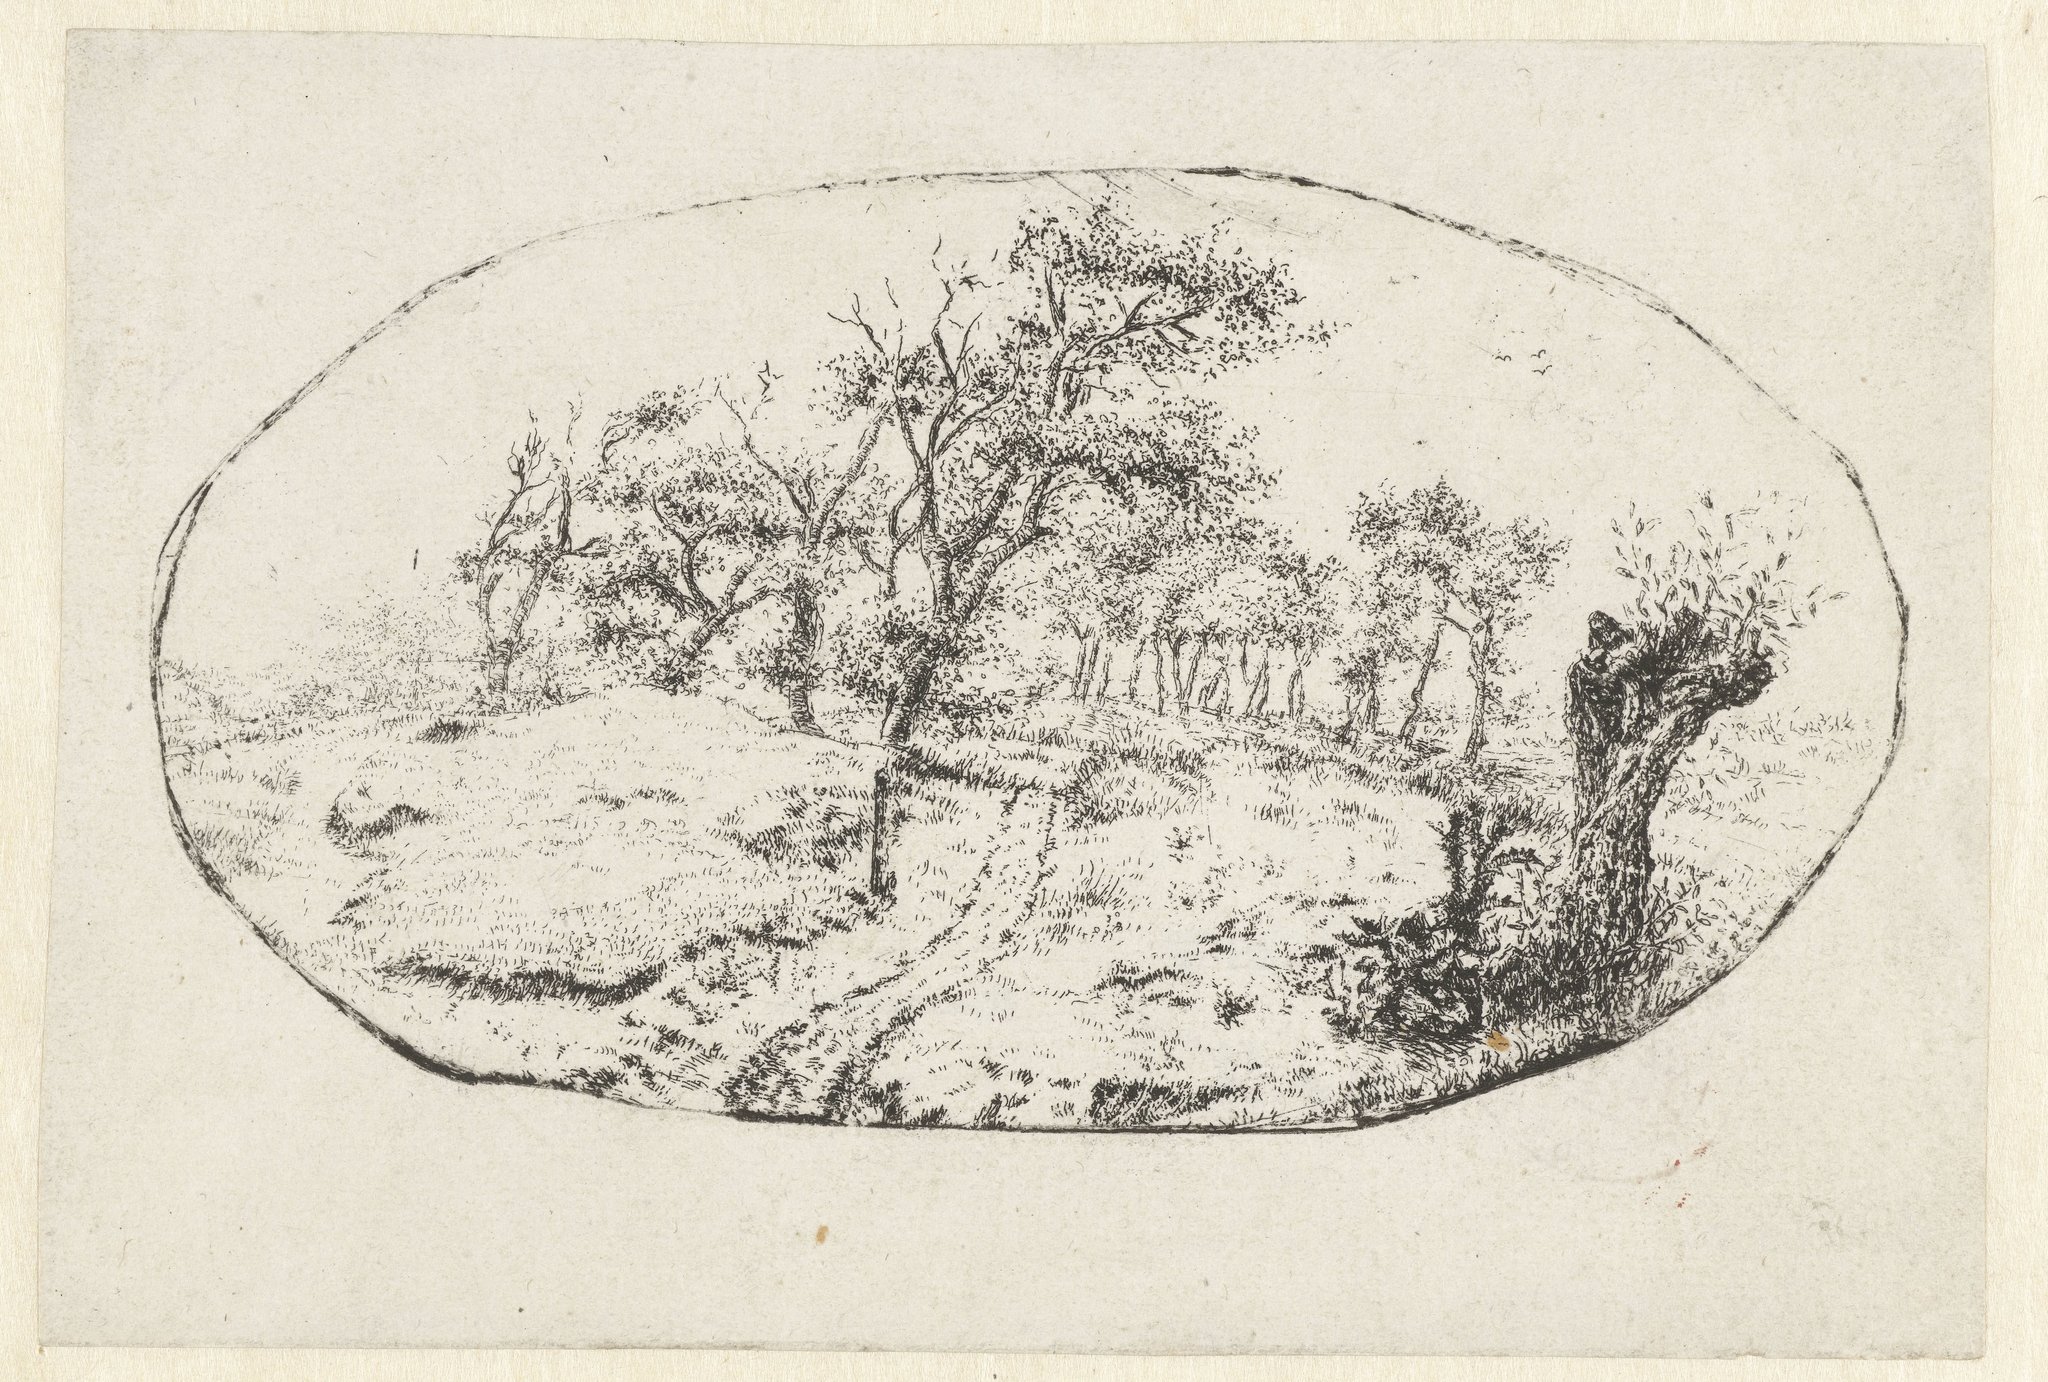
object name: print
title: Landscape in Oval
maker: claes van beresteyn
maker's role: draughtsman, print maker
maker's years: 1627-1684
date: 1637-1684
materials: paper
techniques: etching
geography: netherlands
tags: meadow, pasture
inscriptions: collector's mark: Lugt 240